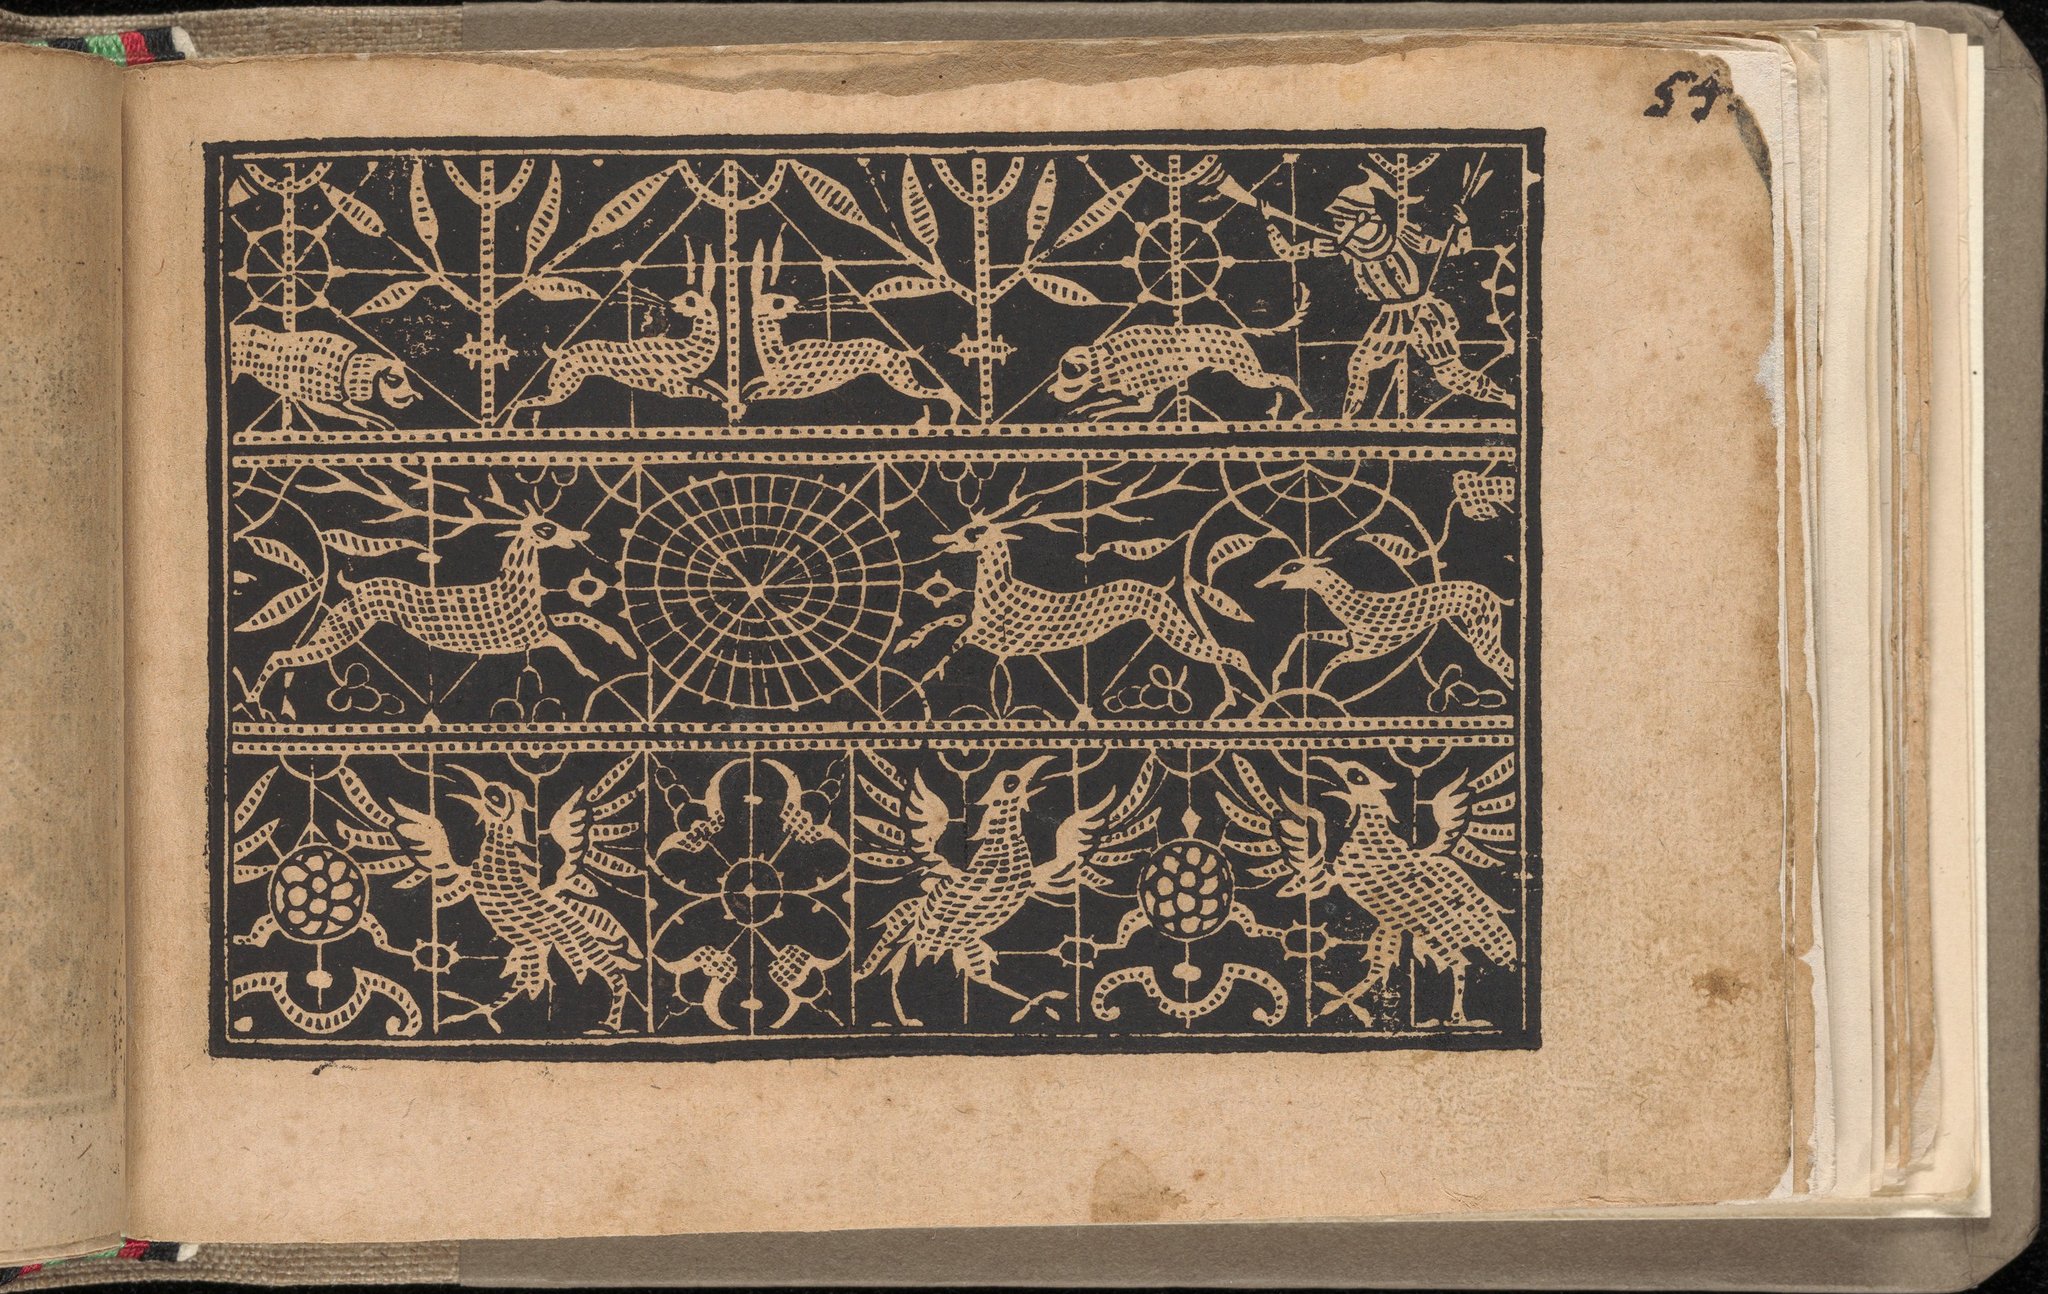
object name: book print ornament architecture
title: Schön newes Modelbuch (Page 54r)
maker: sigismundus latomus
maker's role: publisher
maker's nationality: german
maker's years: 1599-1632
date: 1608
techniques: woodcut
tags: birds,men,deer